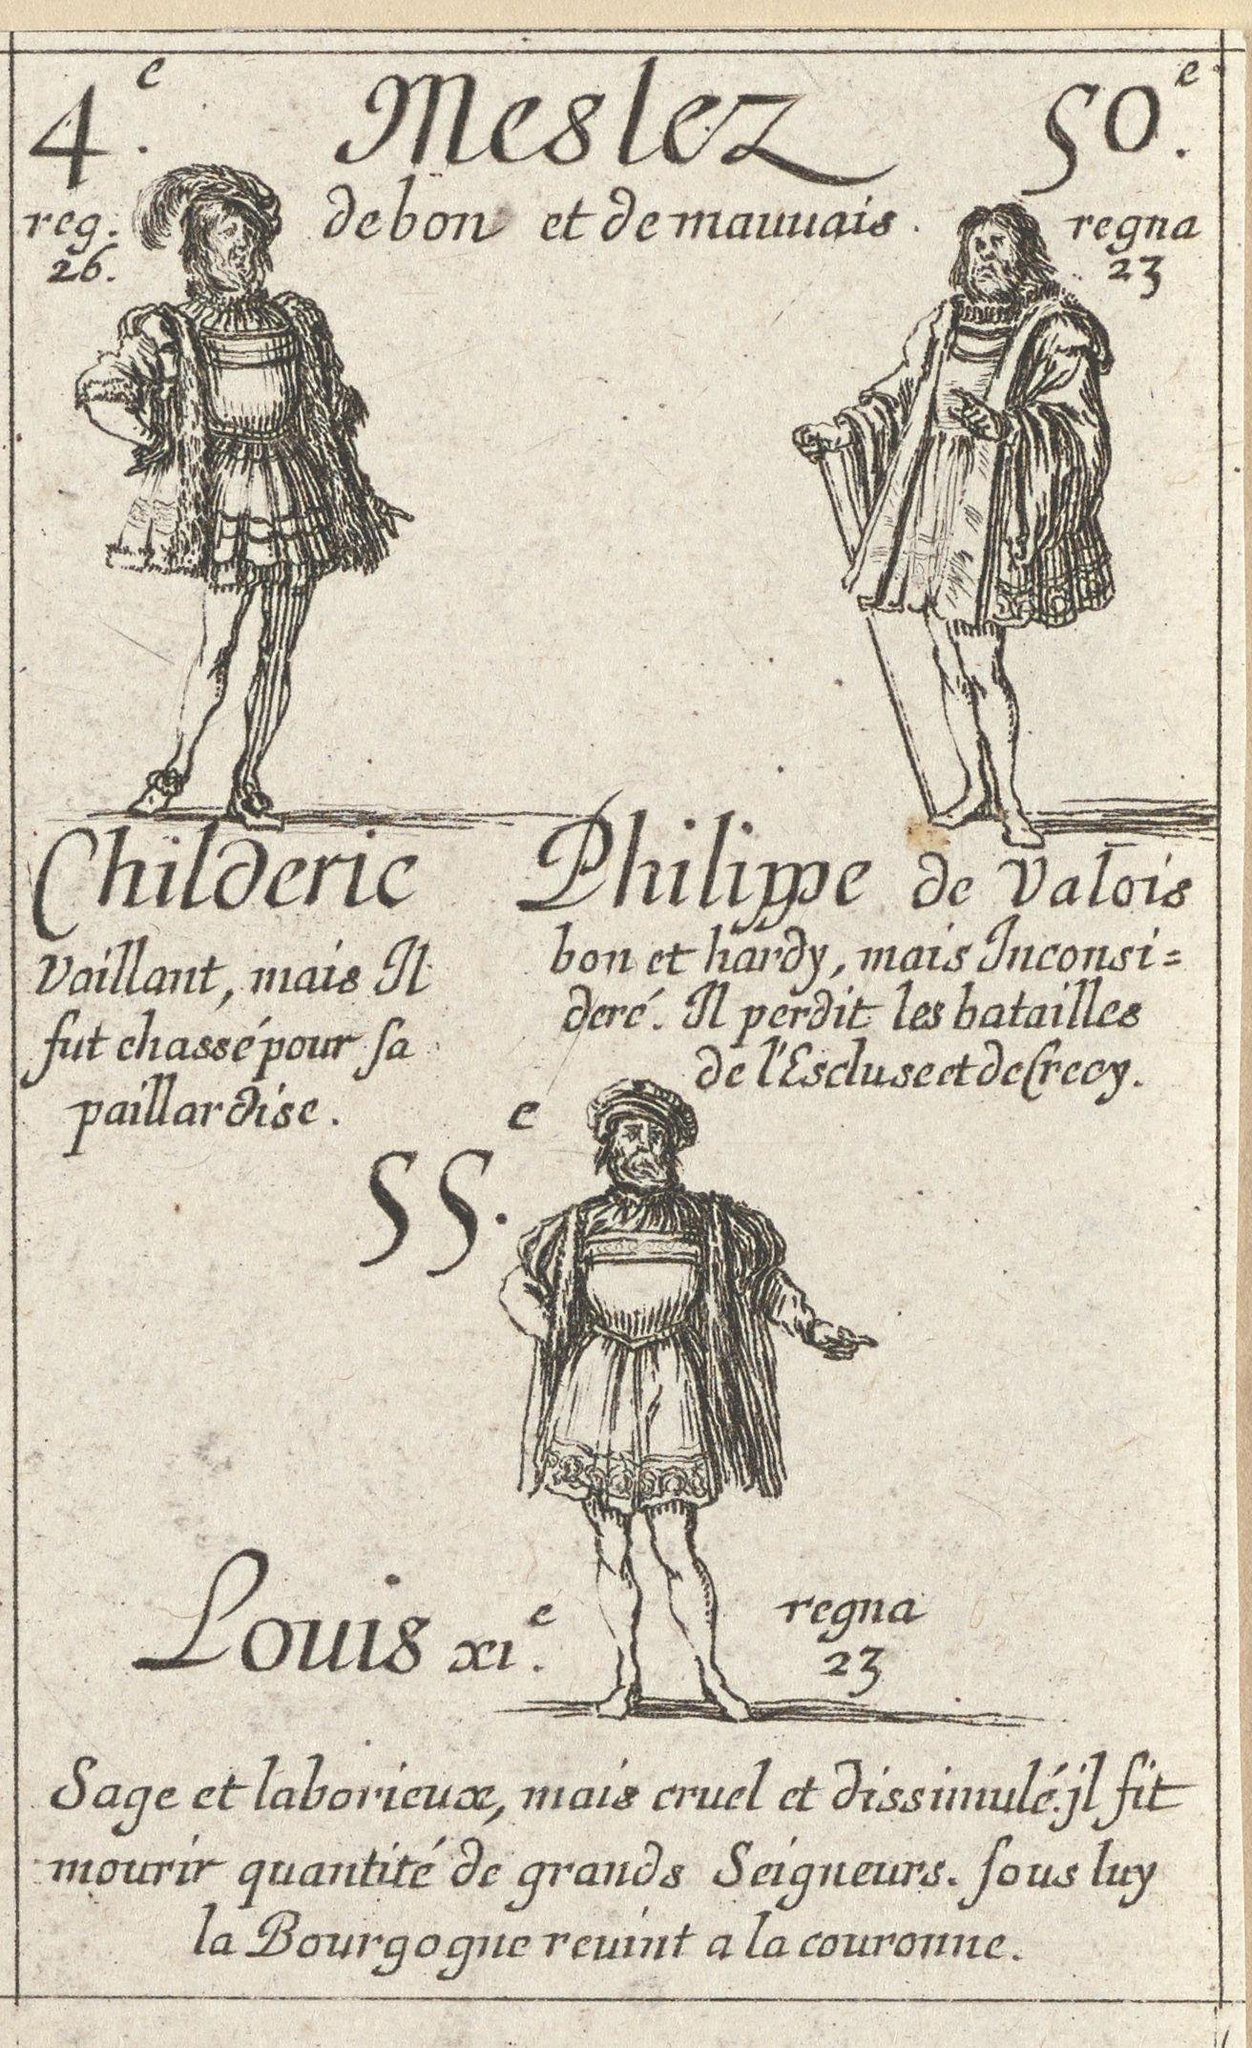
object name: playing card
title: Kaartspel met heersers van Frankrijk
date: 1620-1664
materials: paper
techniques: etching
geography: paris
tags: ruler, sovereign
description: Deze prent maakt deel uit van een kaartspel met 39 kaarten met voorstellingen van Franse koningen. De serie is uitgedacht door Jean Desmarests de Saint-Sorlin in opdracht van Kardinaal Mazarin. Het kaartspel werd gemaakt voor de jonge Lodewijk XIV, samen met het Jeu des Fables, Jeu des Reynes Renommées en Jeu de la géographie.